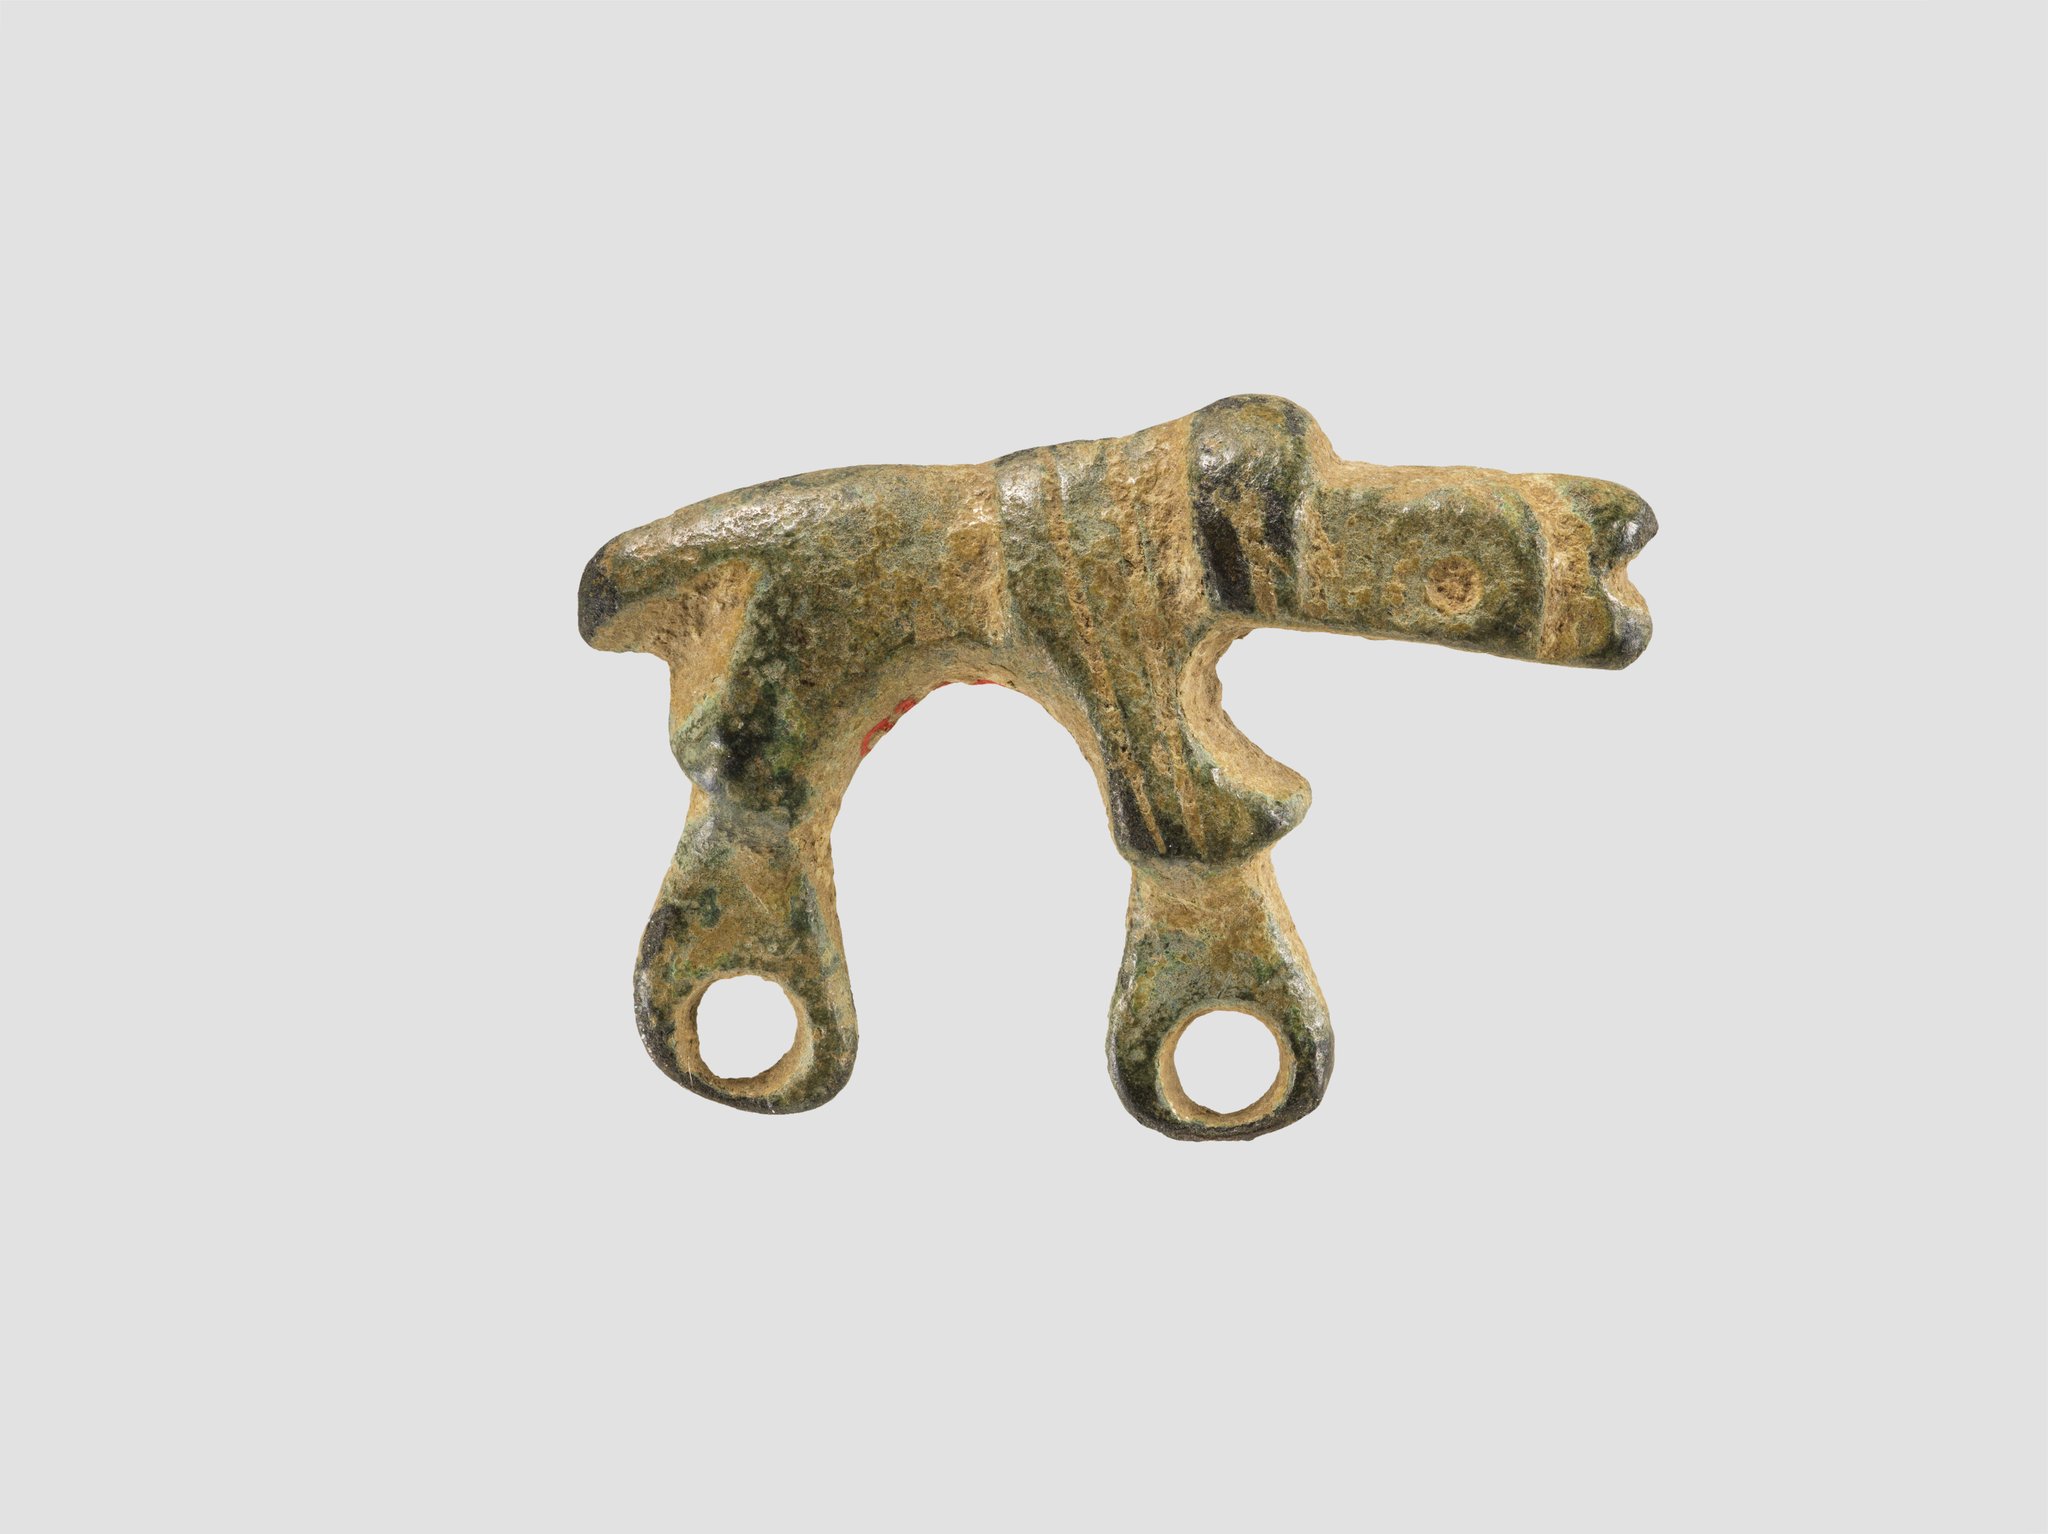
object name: ornament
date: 500-301 BCE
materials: bronze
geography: eastern eurasian steppes